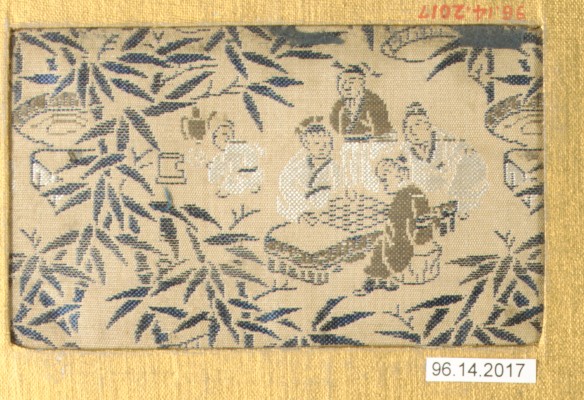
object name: piece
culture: japanese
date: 1701-1900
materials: silk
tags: leaves